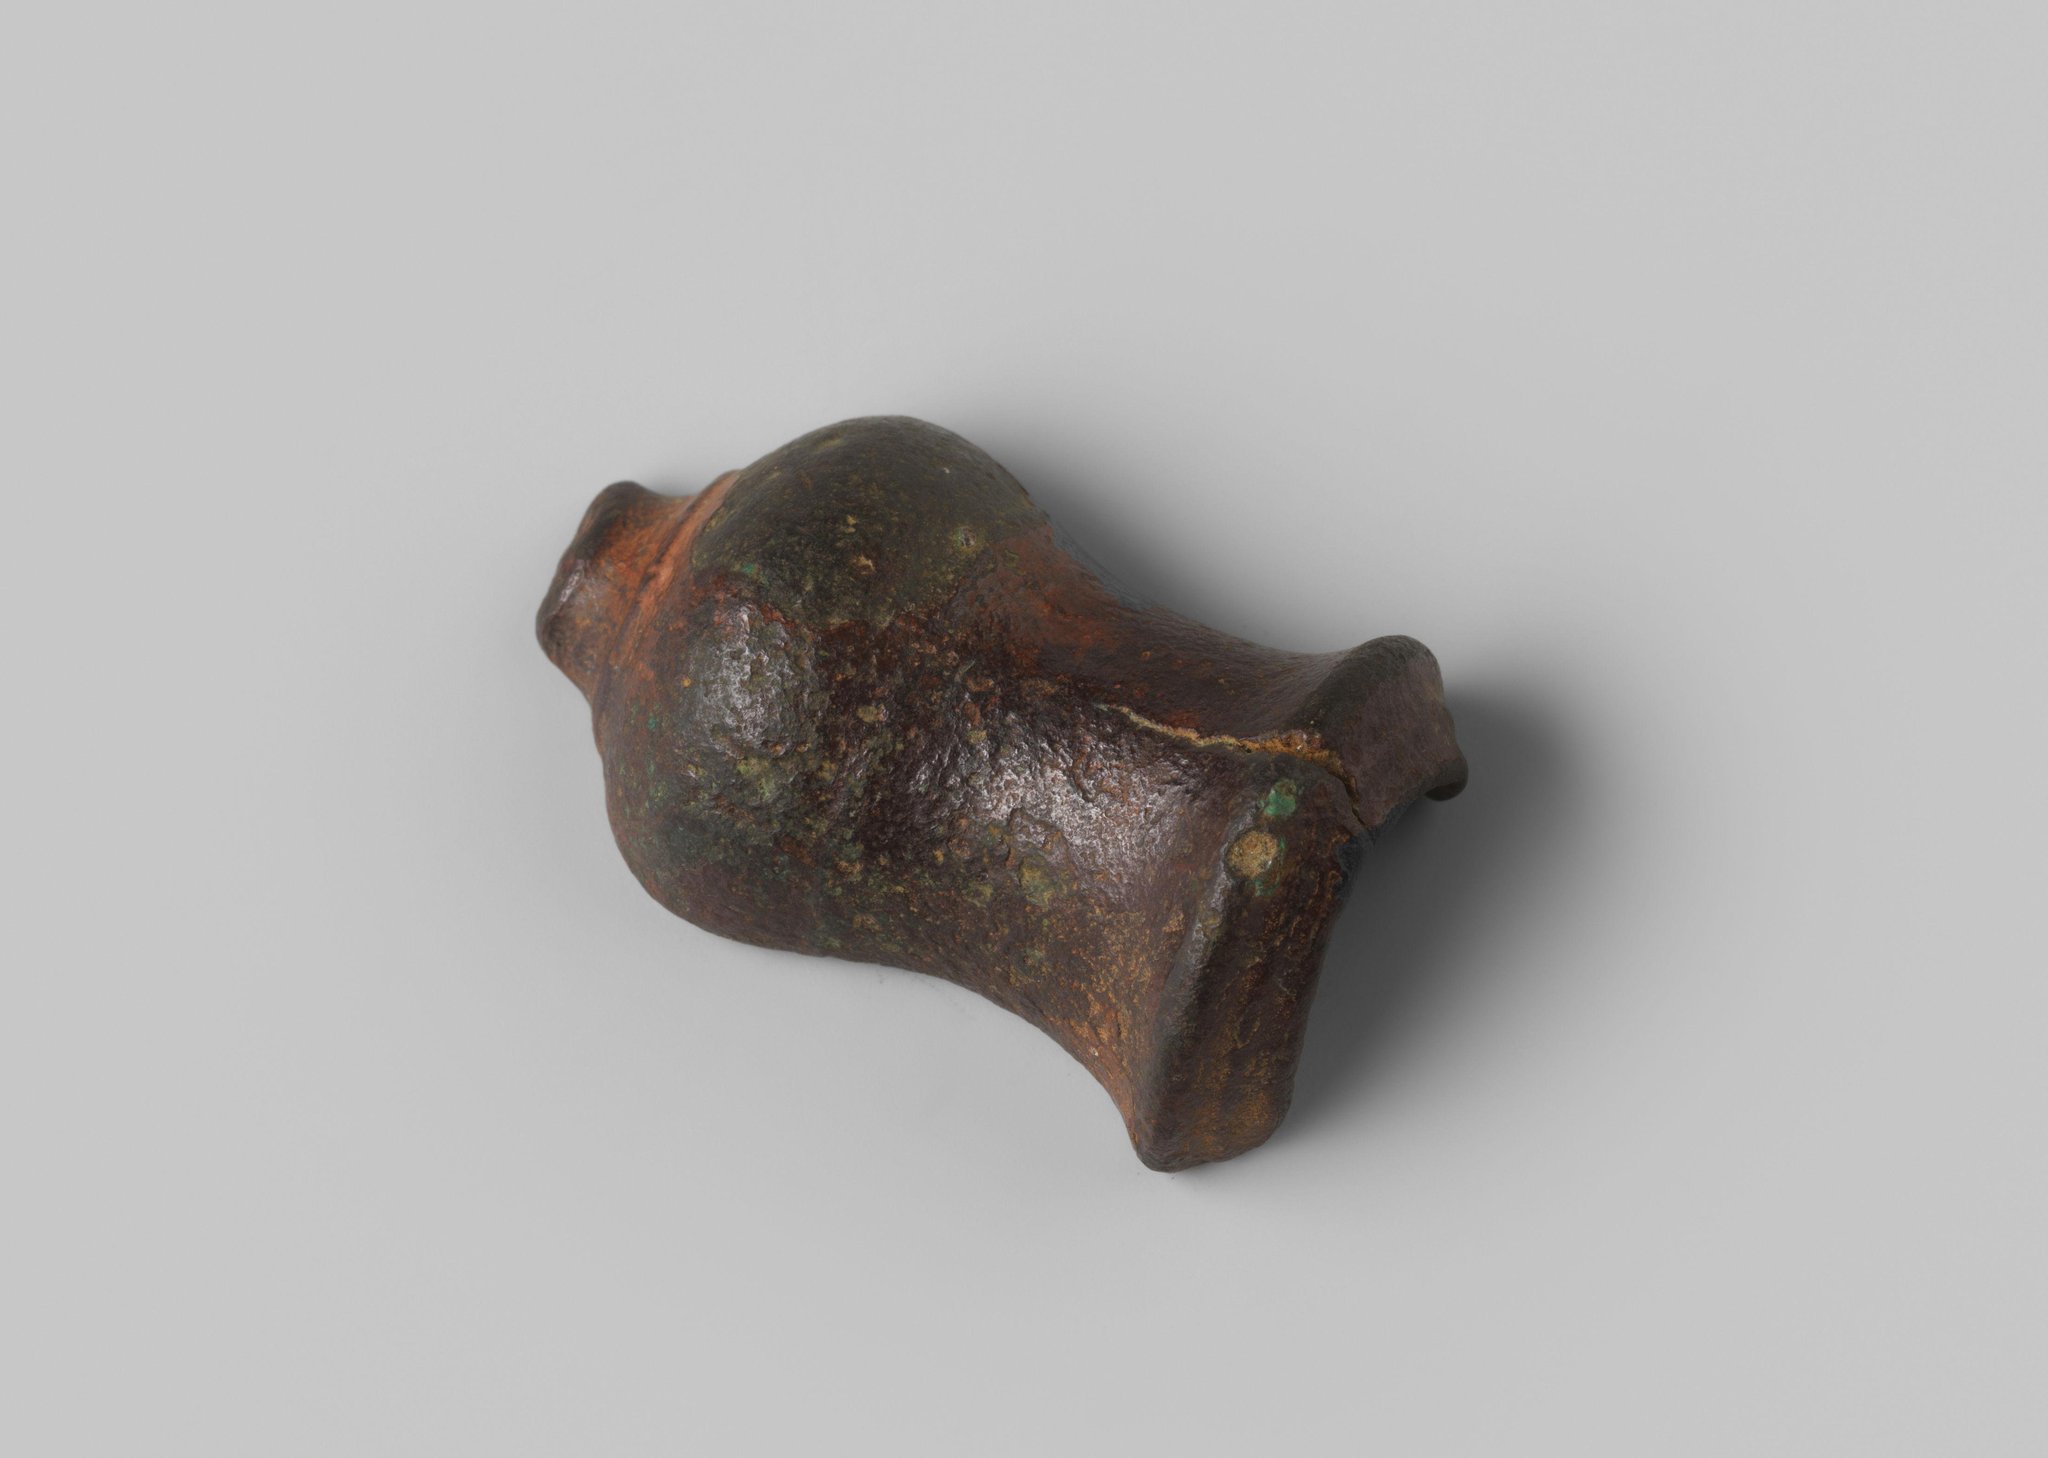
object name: candlestick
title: Fragment steel van een kandelaar uit het wrak van de Oost-Indiëvaarder Hollandia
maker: Anonymous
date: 1700-1743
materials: copper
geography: netherlands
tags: verenigde oostindische compagnie, hollandia (schip), annet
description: Candlestick, stem; fragm, half part of socket, baluster(tulip)-shaped, plain, bevelled rim, hollow.